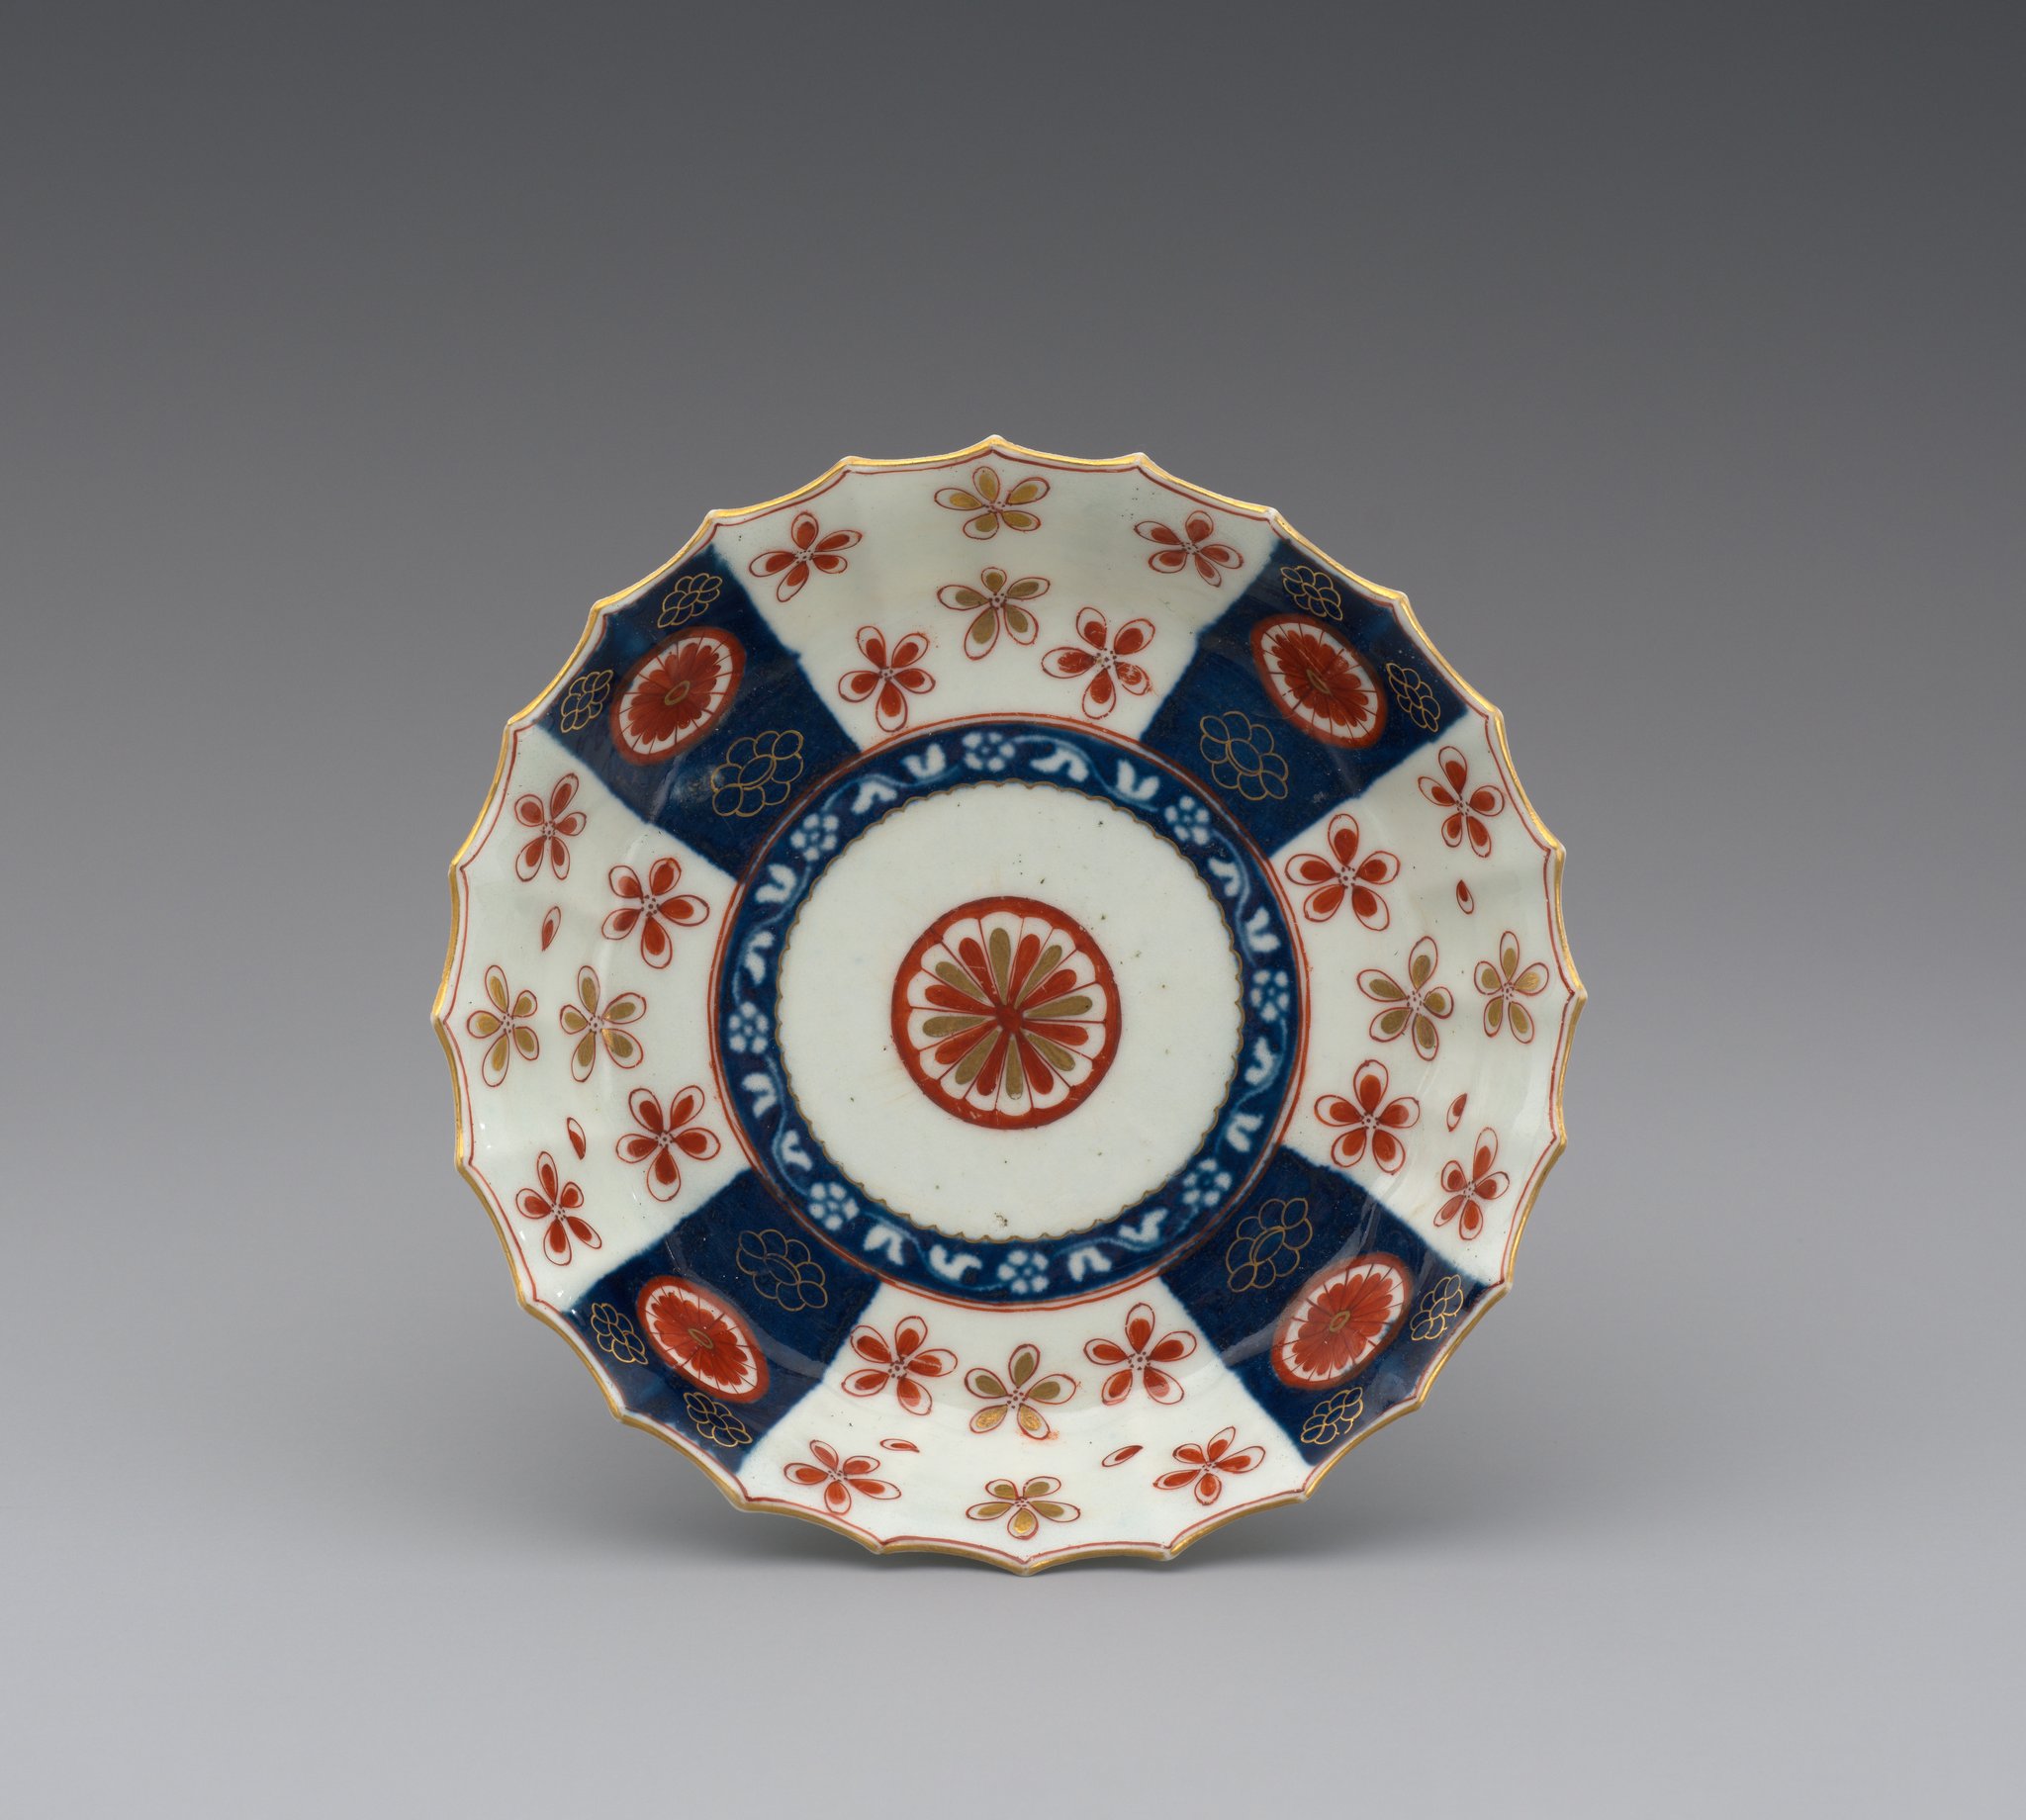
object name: saucer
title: Saucer (part of a service)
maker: worcester factory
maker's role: factory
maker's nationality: british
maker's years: 1751-2008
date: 1765-1775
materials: soft paste porcelain